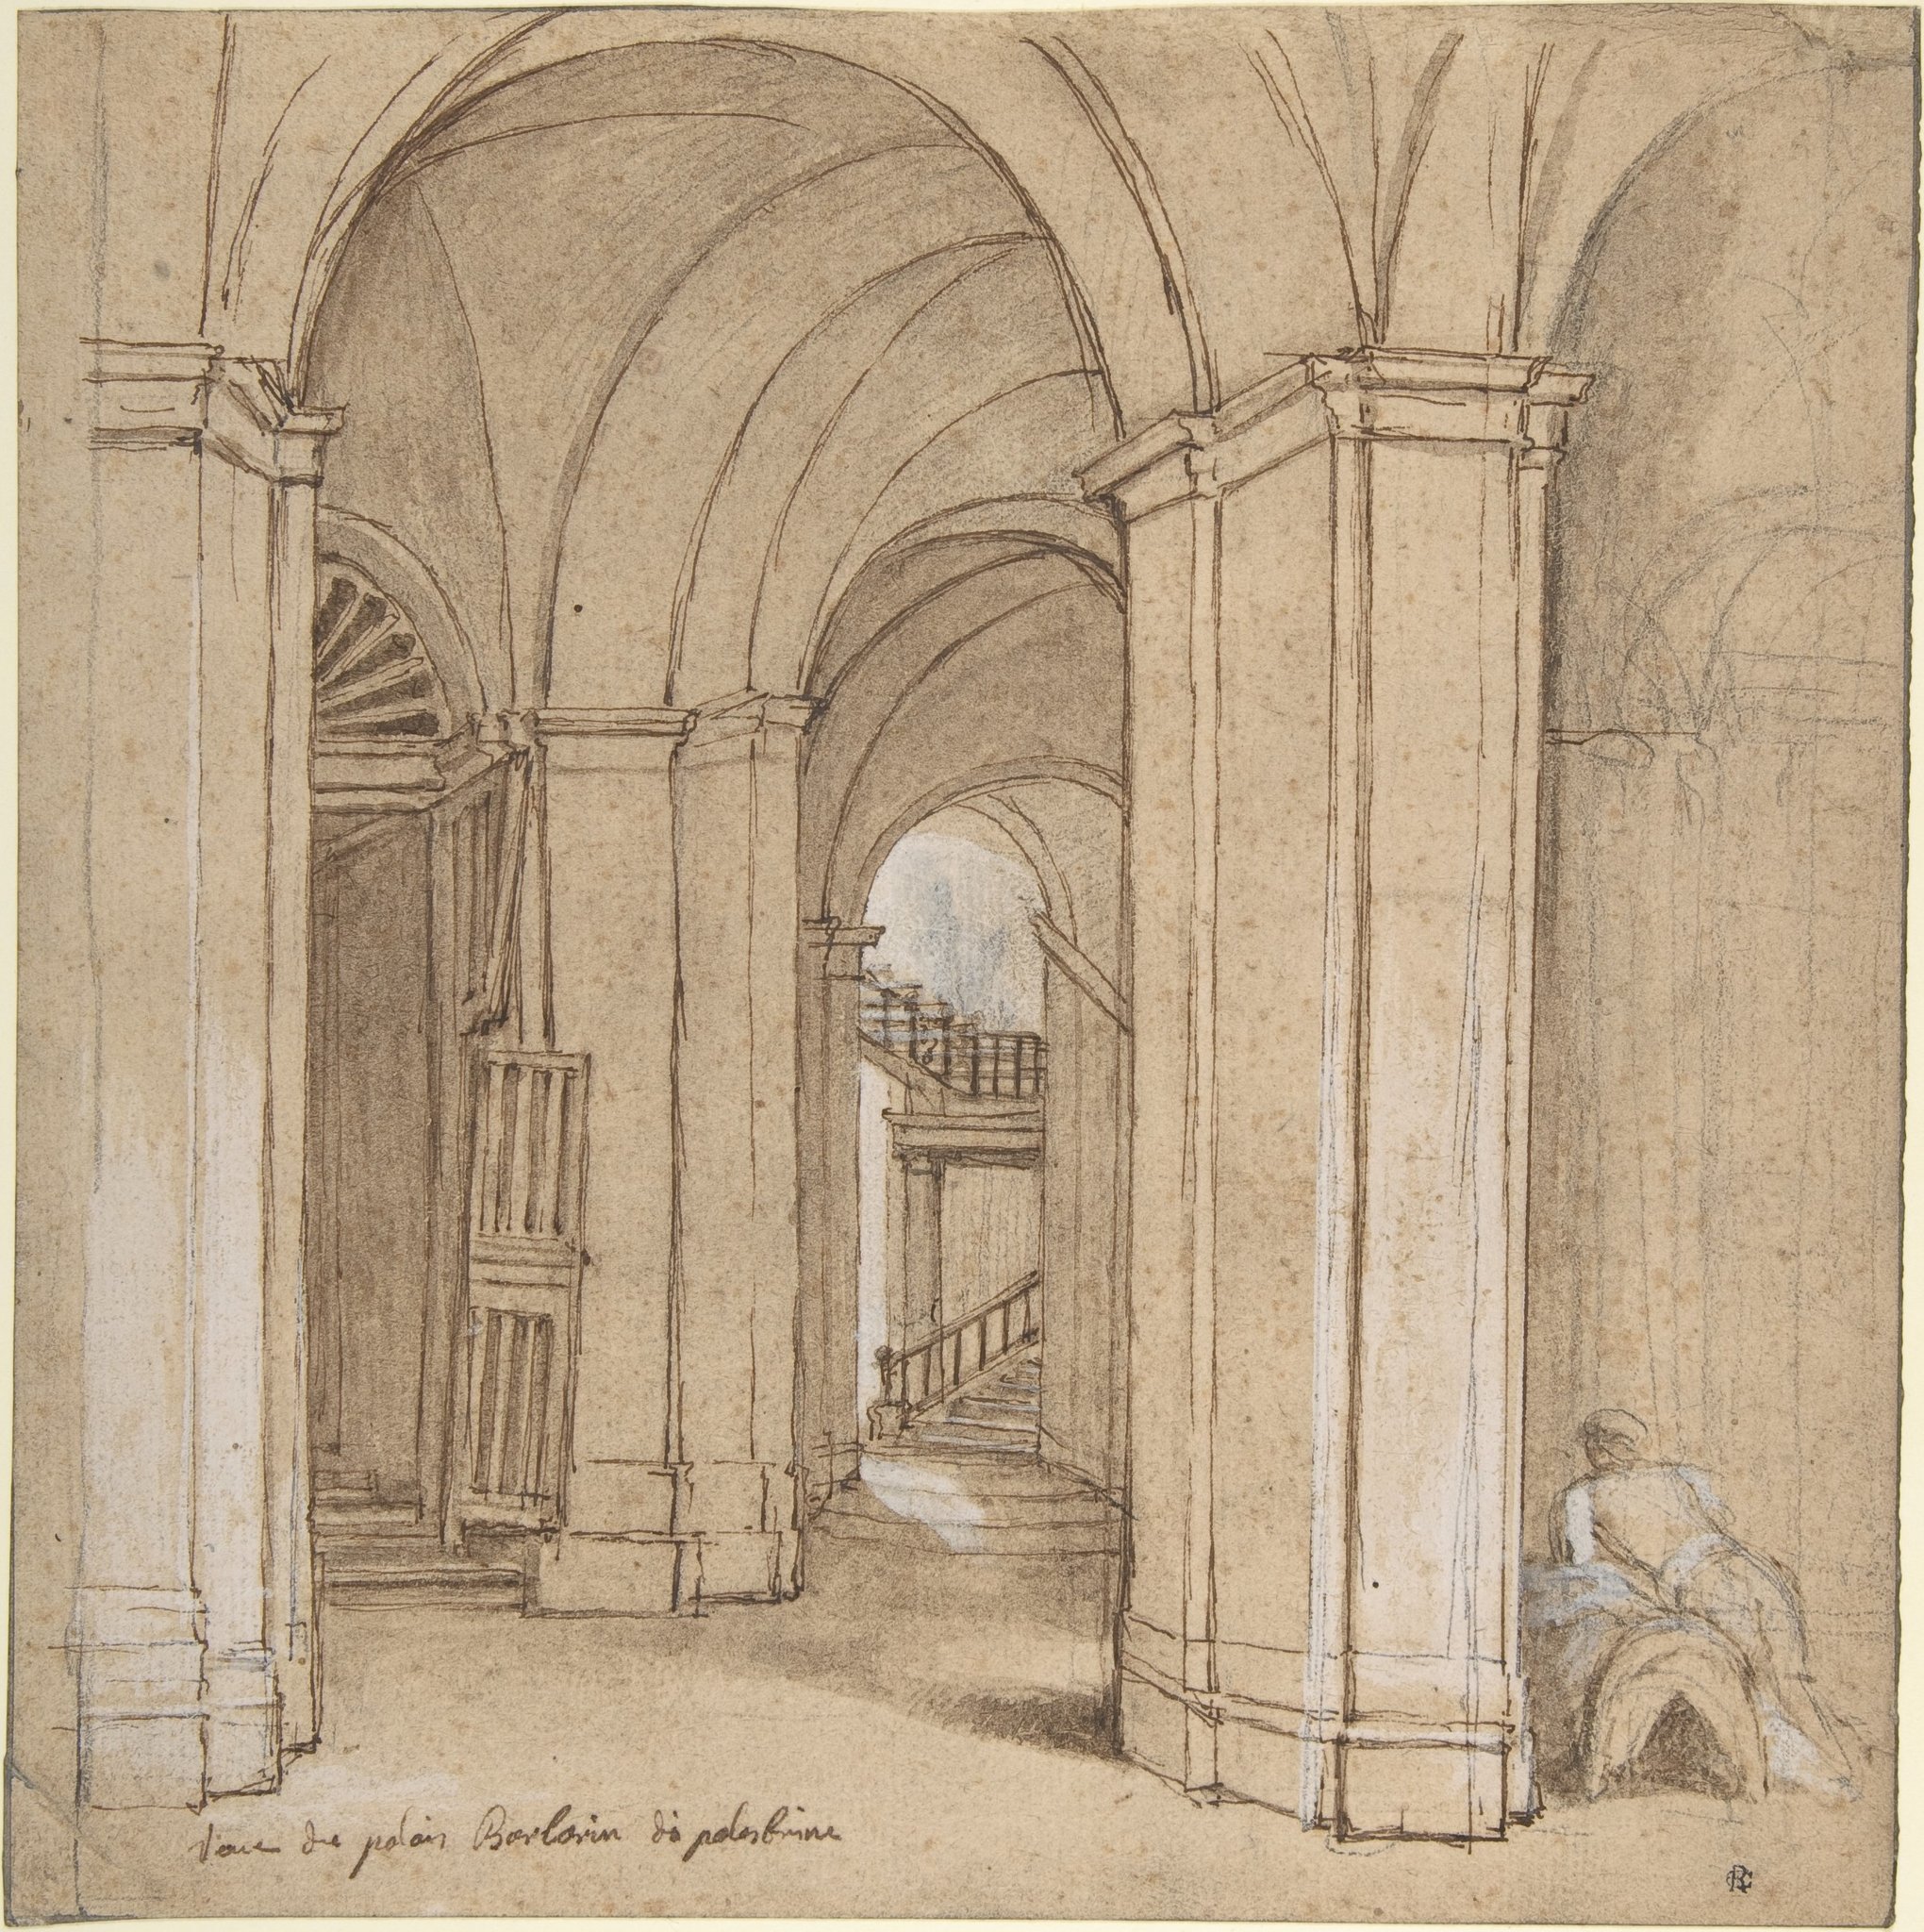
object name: drawing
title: Staircase in the Palazzo Barberini, Palestrina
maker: charles joseph natoire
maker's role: artist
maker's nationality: french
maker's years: 1700-1777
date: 1734-1766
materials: chalk, ink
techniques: brush, heightening, pen, wash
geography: france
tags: arches,stairs